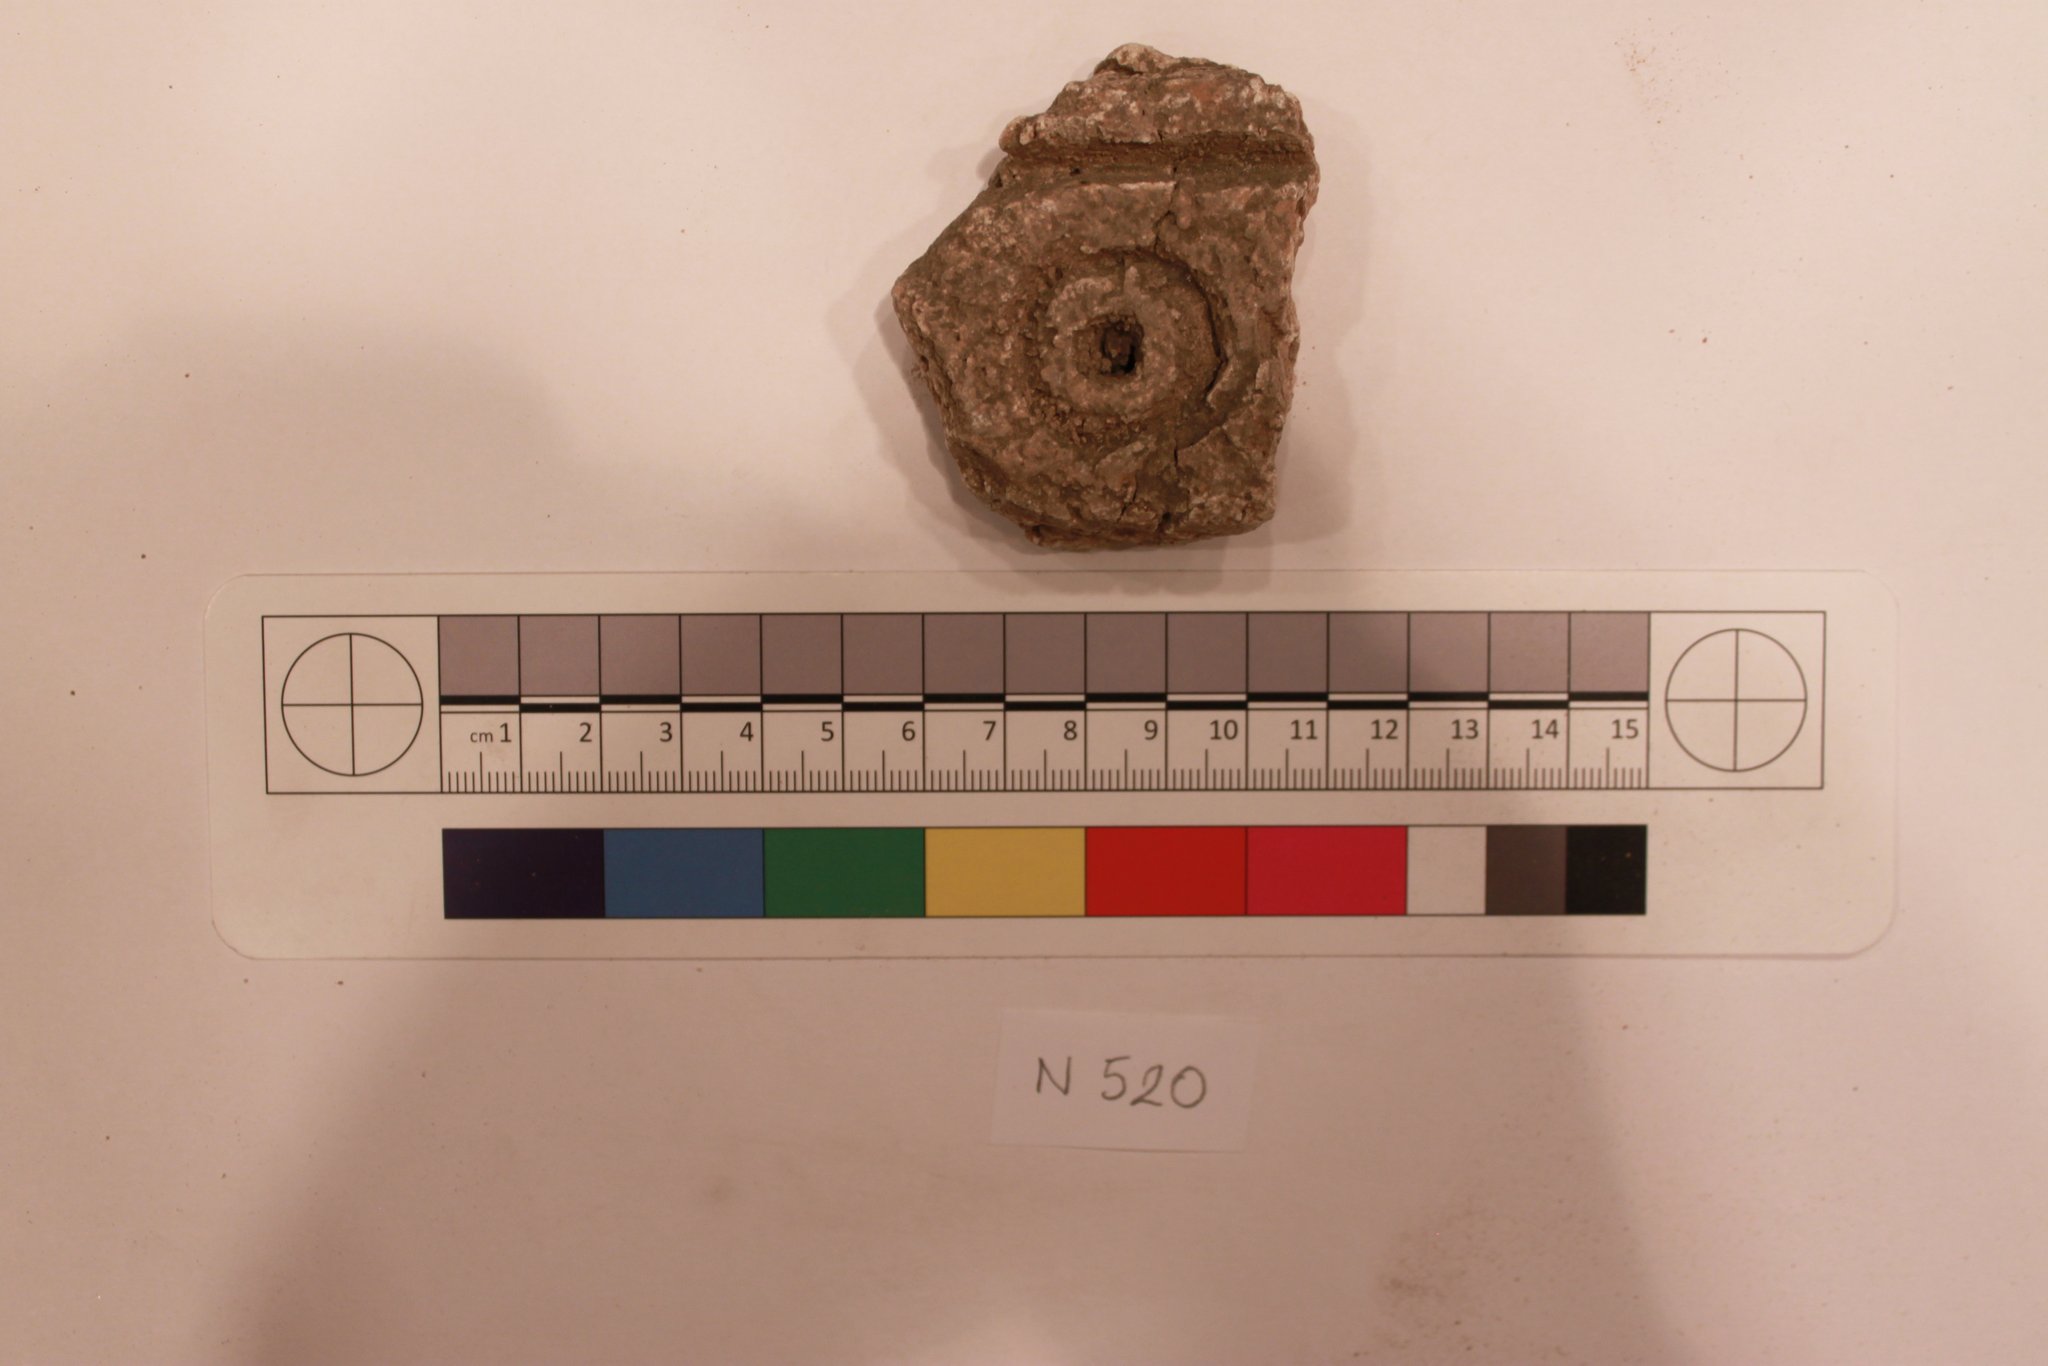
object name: fragment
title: Stucco Fragment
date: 701-1200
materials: plaster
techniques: carving, painting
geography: iran